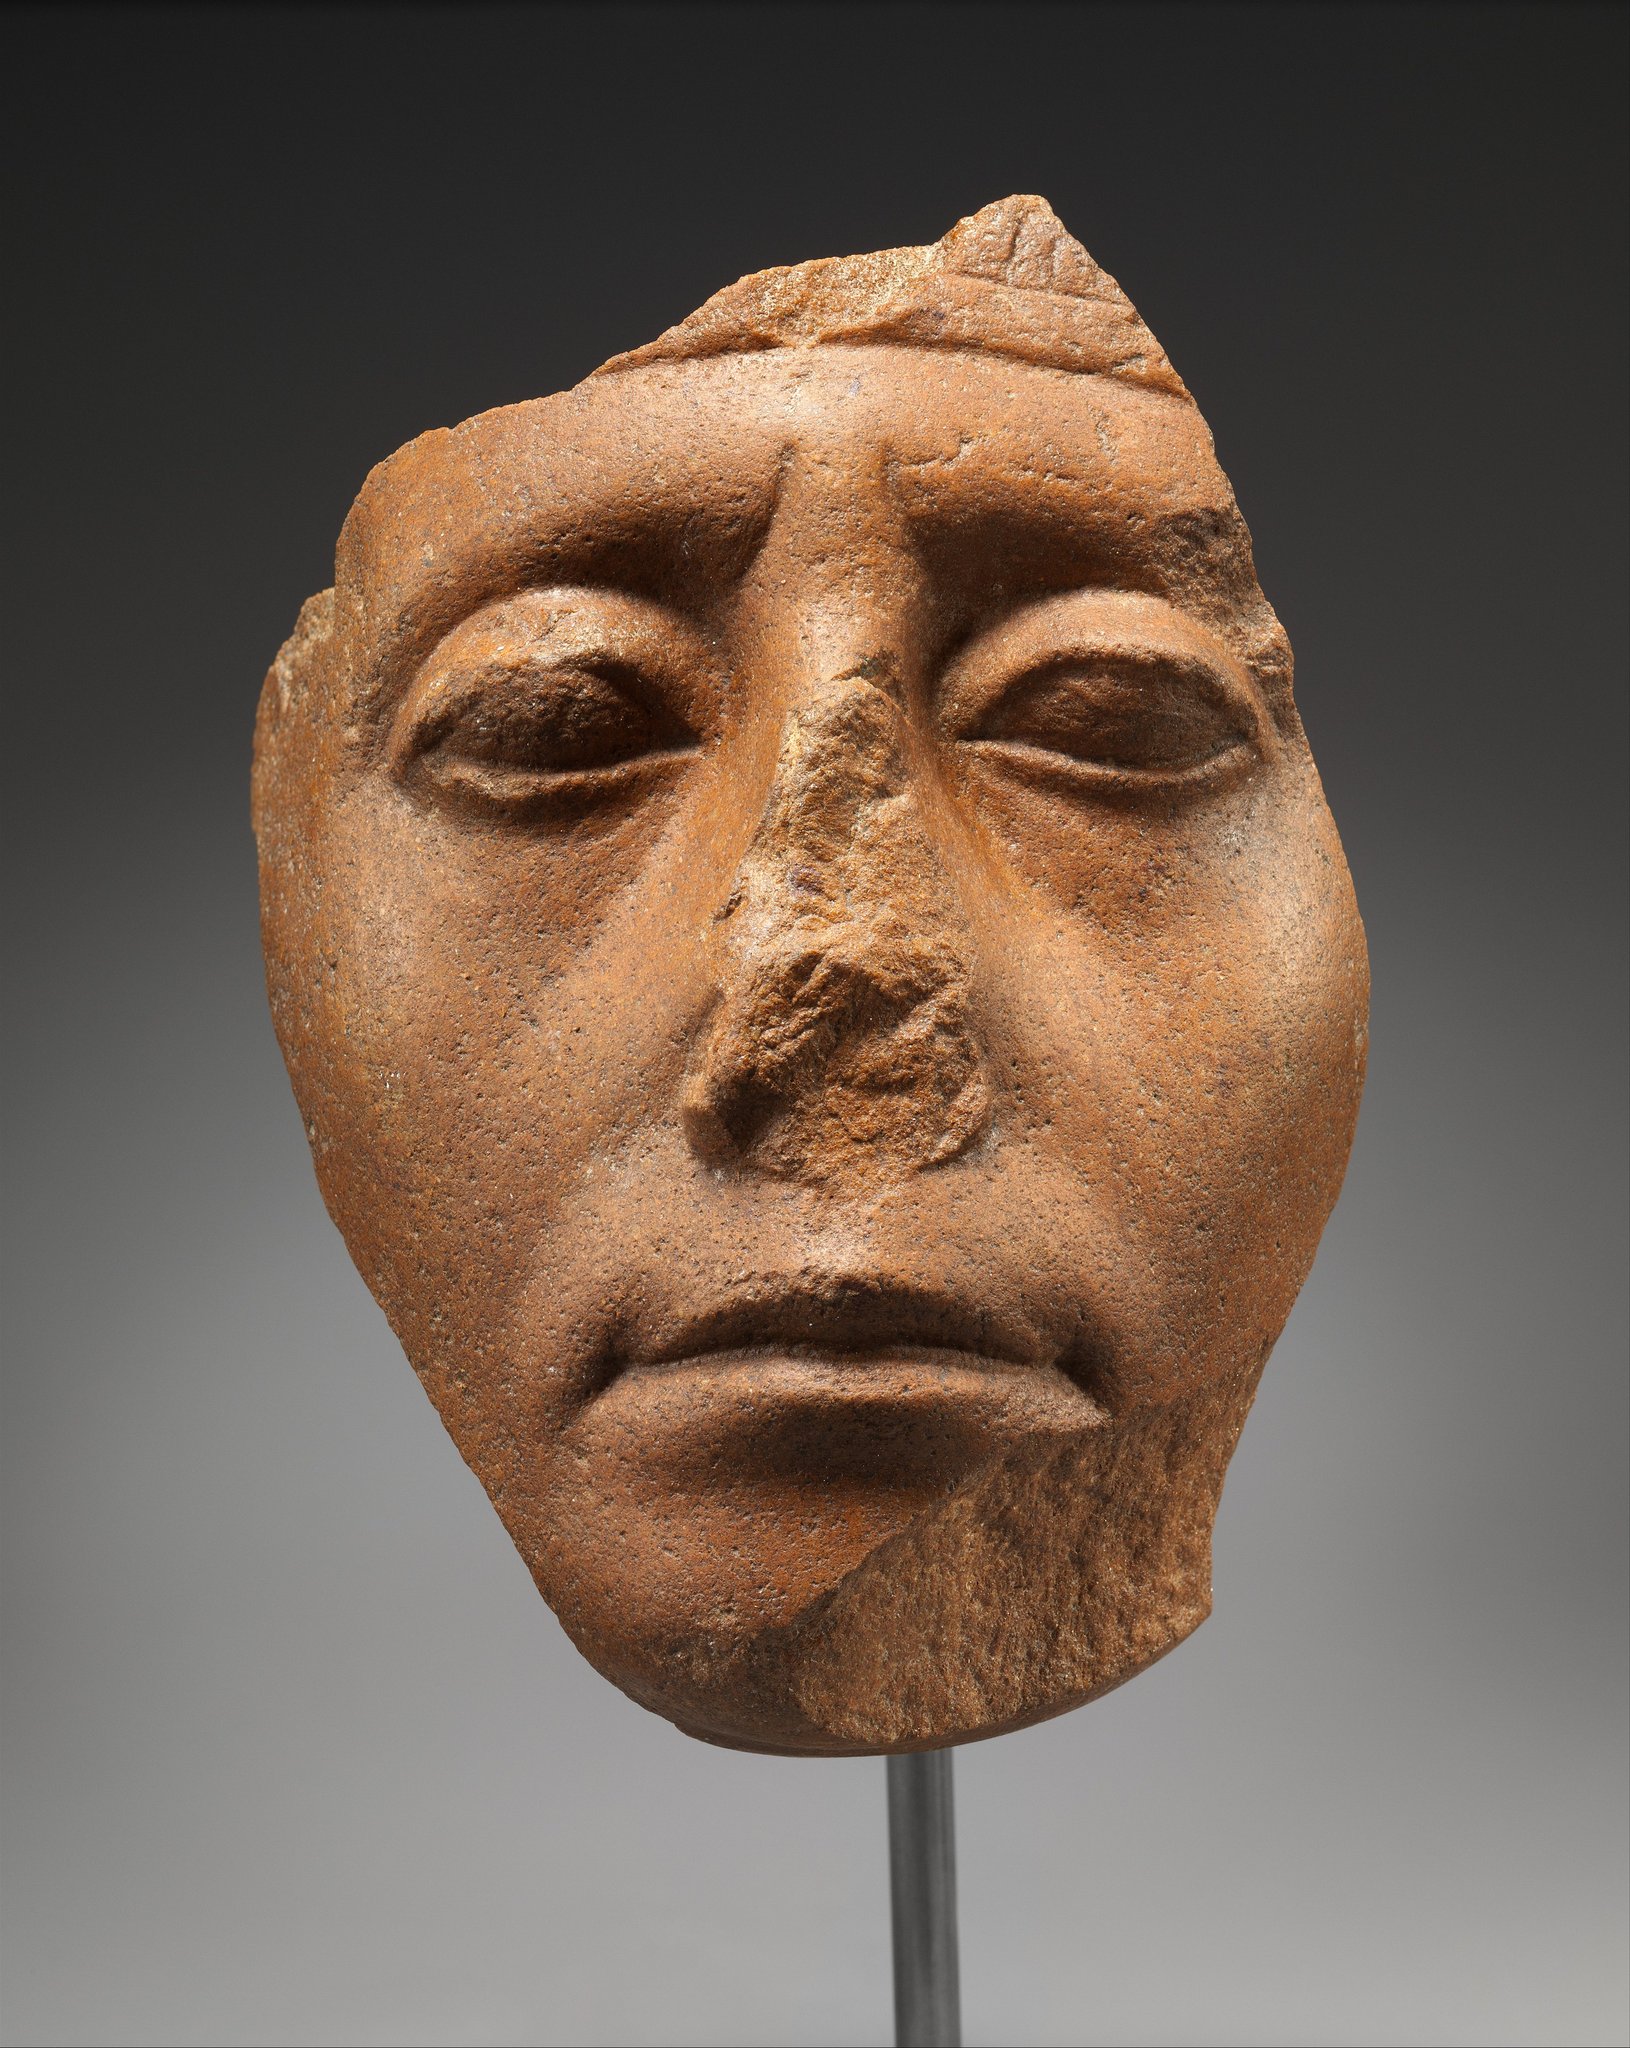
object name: head, senwosret iii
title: Face of Senwosret III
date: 1878-1840 BCE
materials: quartzite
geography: egypt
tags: kings,faces,men,portraits,mk-kings